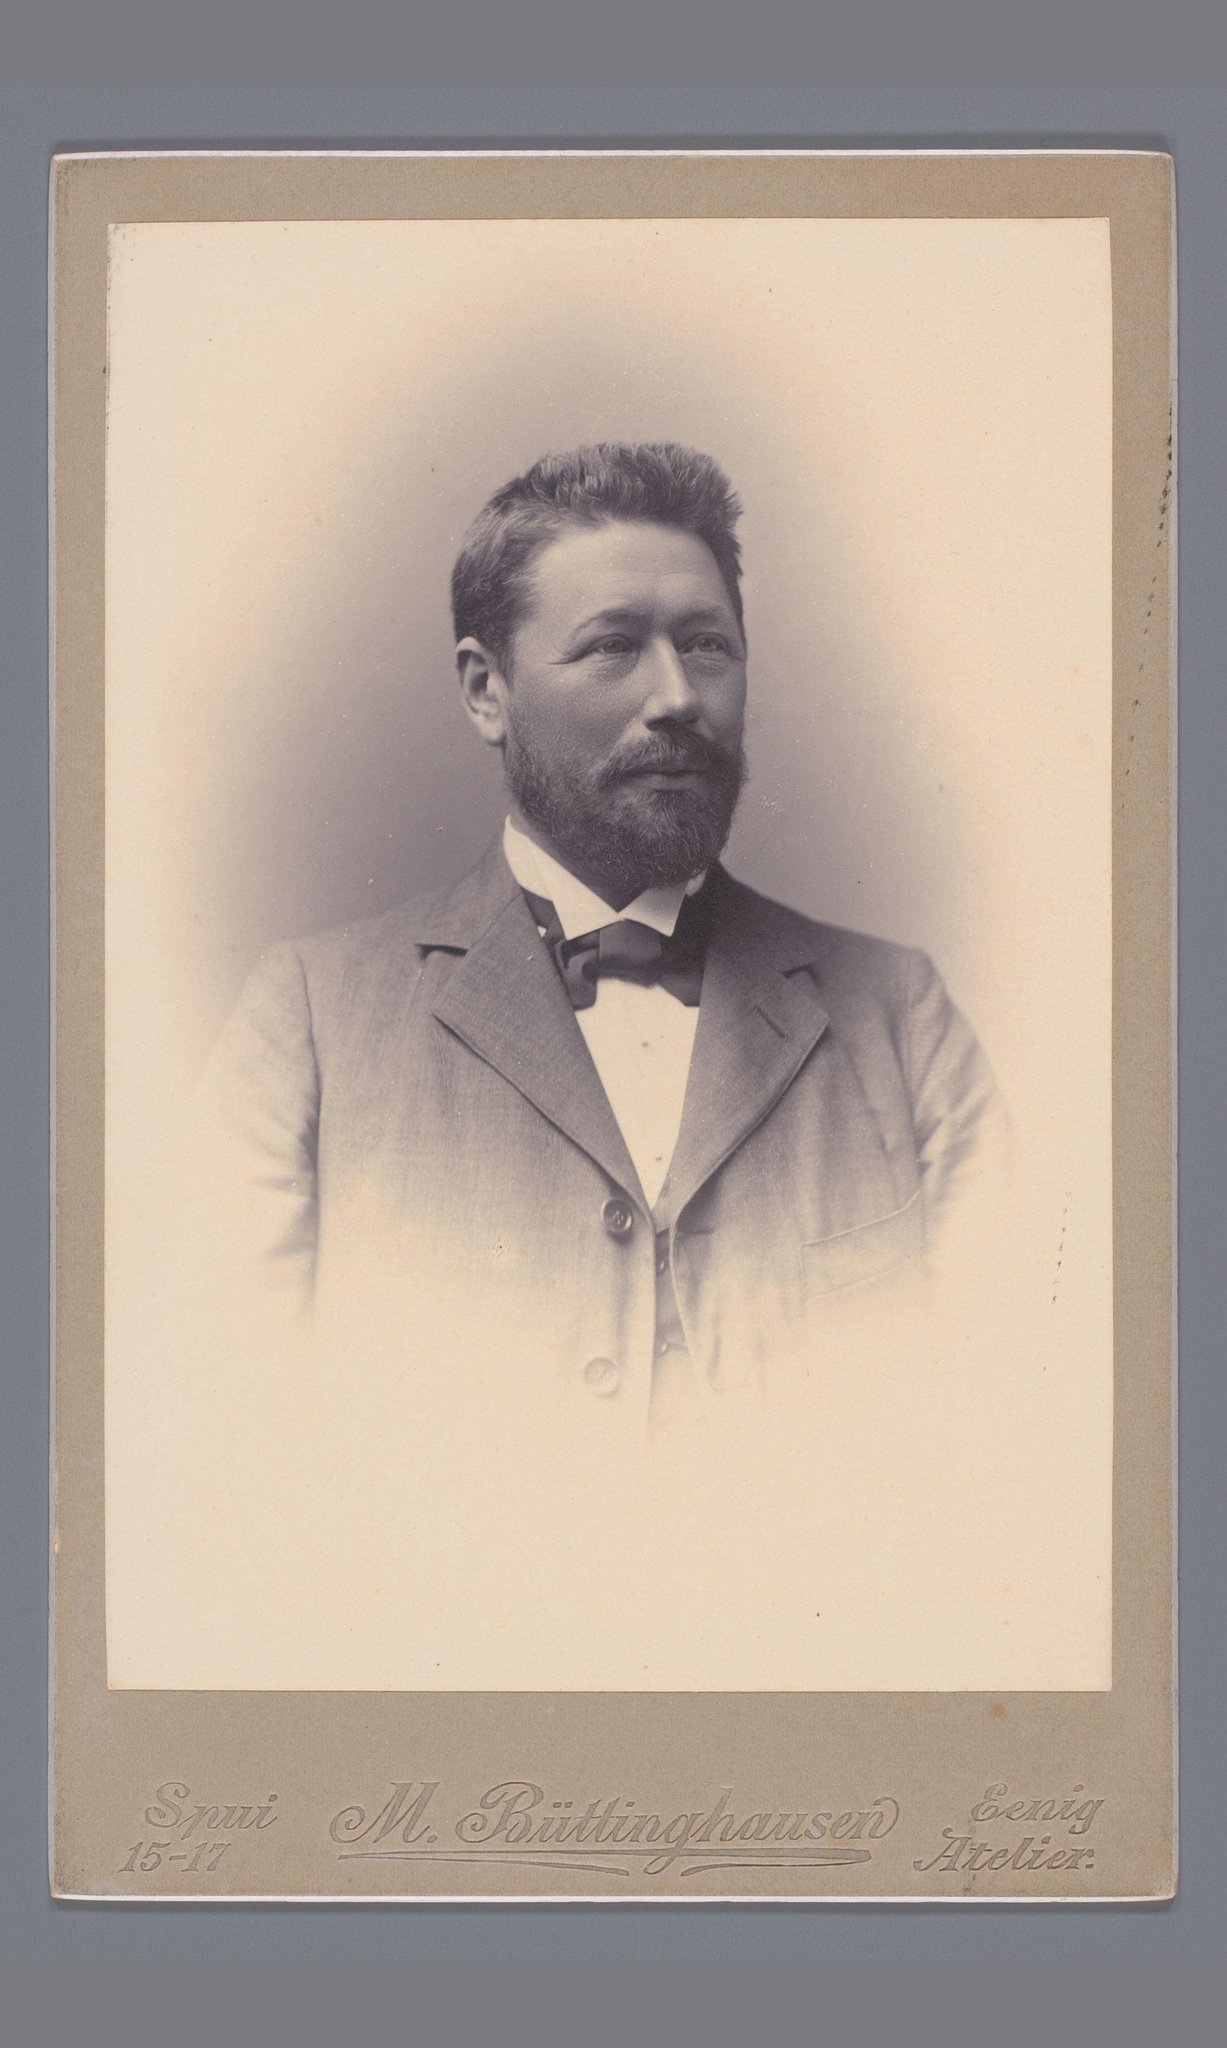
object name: cabinet photograph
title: Portret van een onbekende man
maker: max büttinghausen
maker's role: fotograaf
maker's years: 1847-1906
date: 1895-1906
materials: cardboard, photographic support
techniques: collodion silver print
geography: amsterdam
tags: historical persons, amsterdam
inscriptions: workshop stamp: ‘M. Büttinghausen/ Amsterdam, Spui 15-17 b. de Kalverstraat/ eenig Atelier/ Telefoon No. 1482’